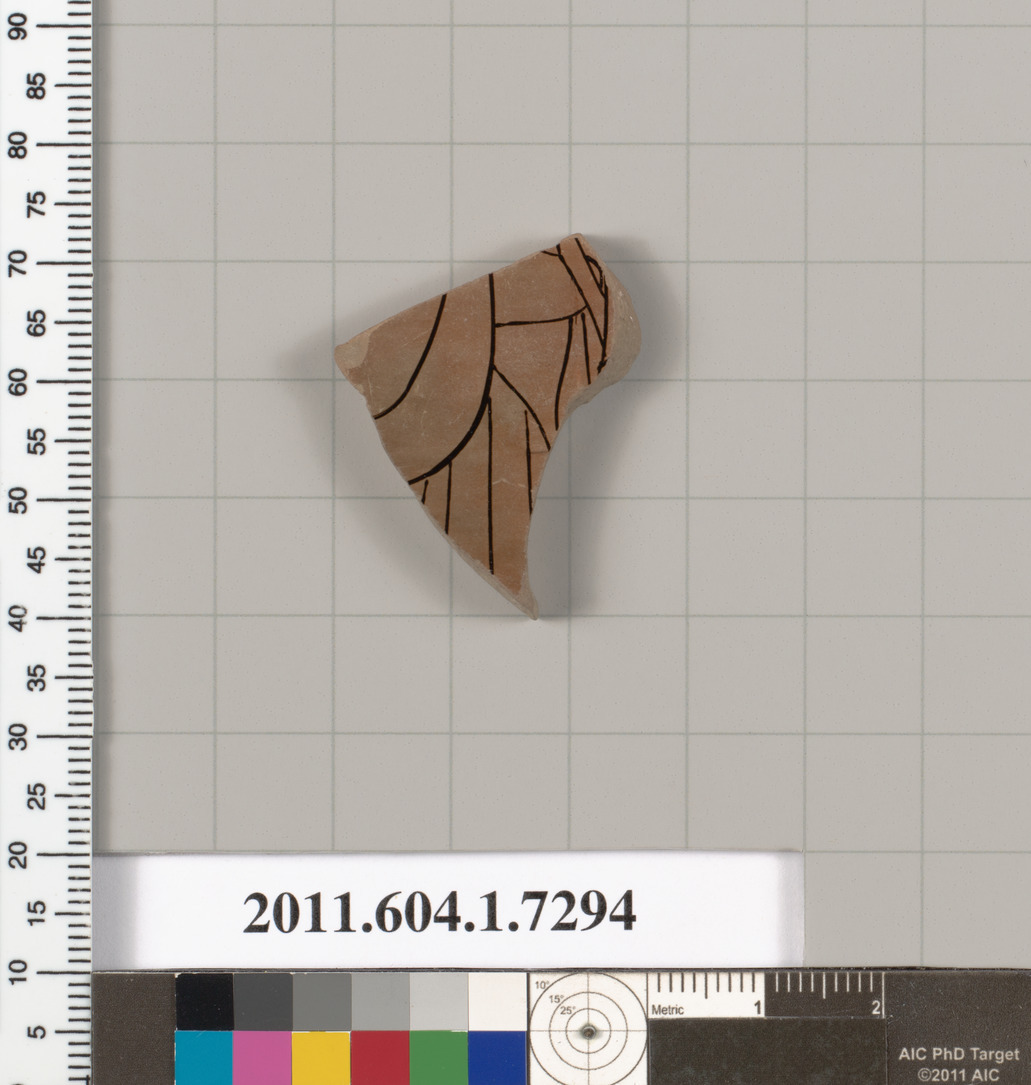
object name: kylix fragment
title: Terracotta fragment of a kylix (drinking cup)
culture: greek, attic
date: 500-480 BCE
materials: terracotta